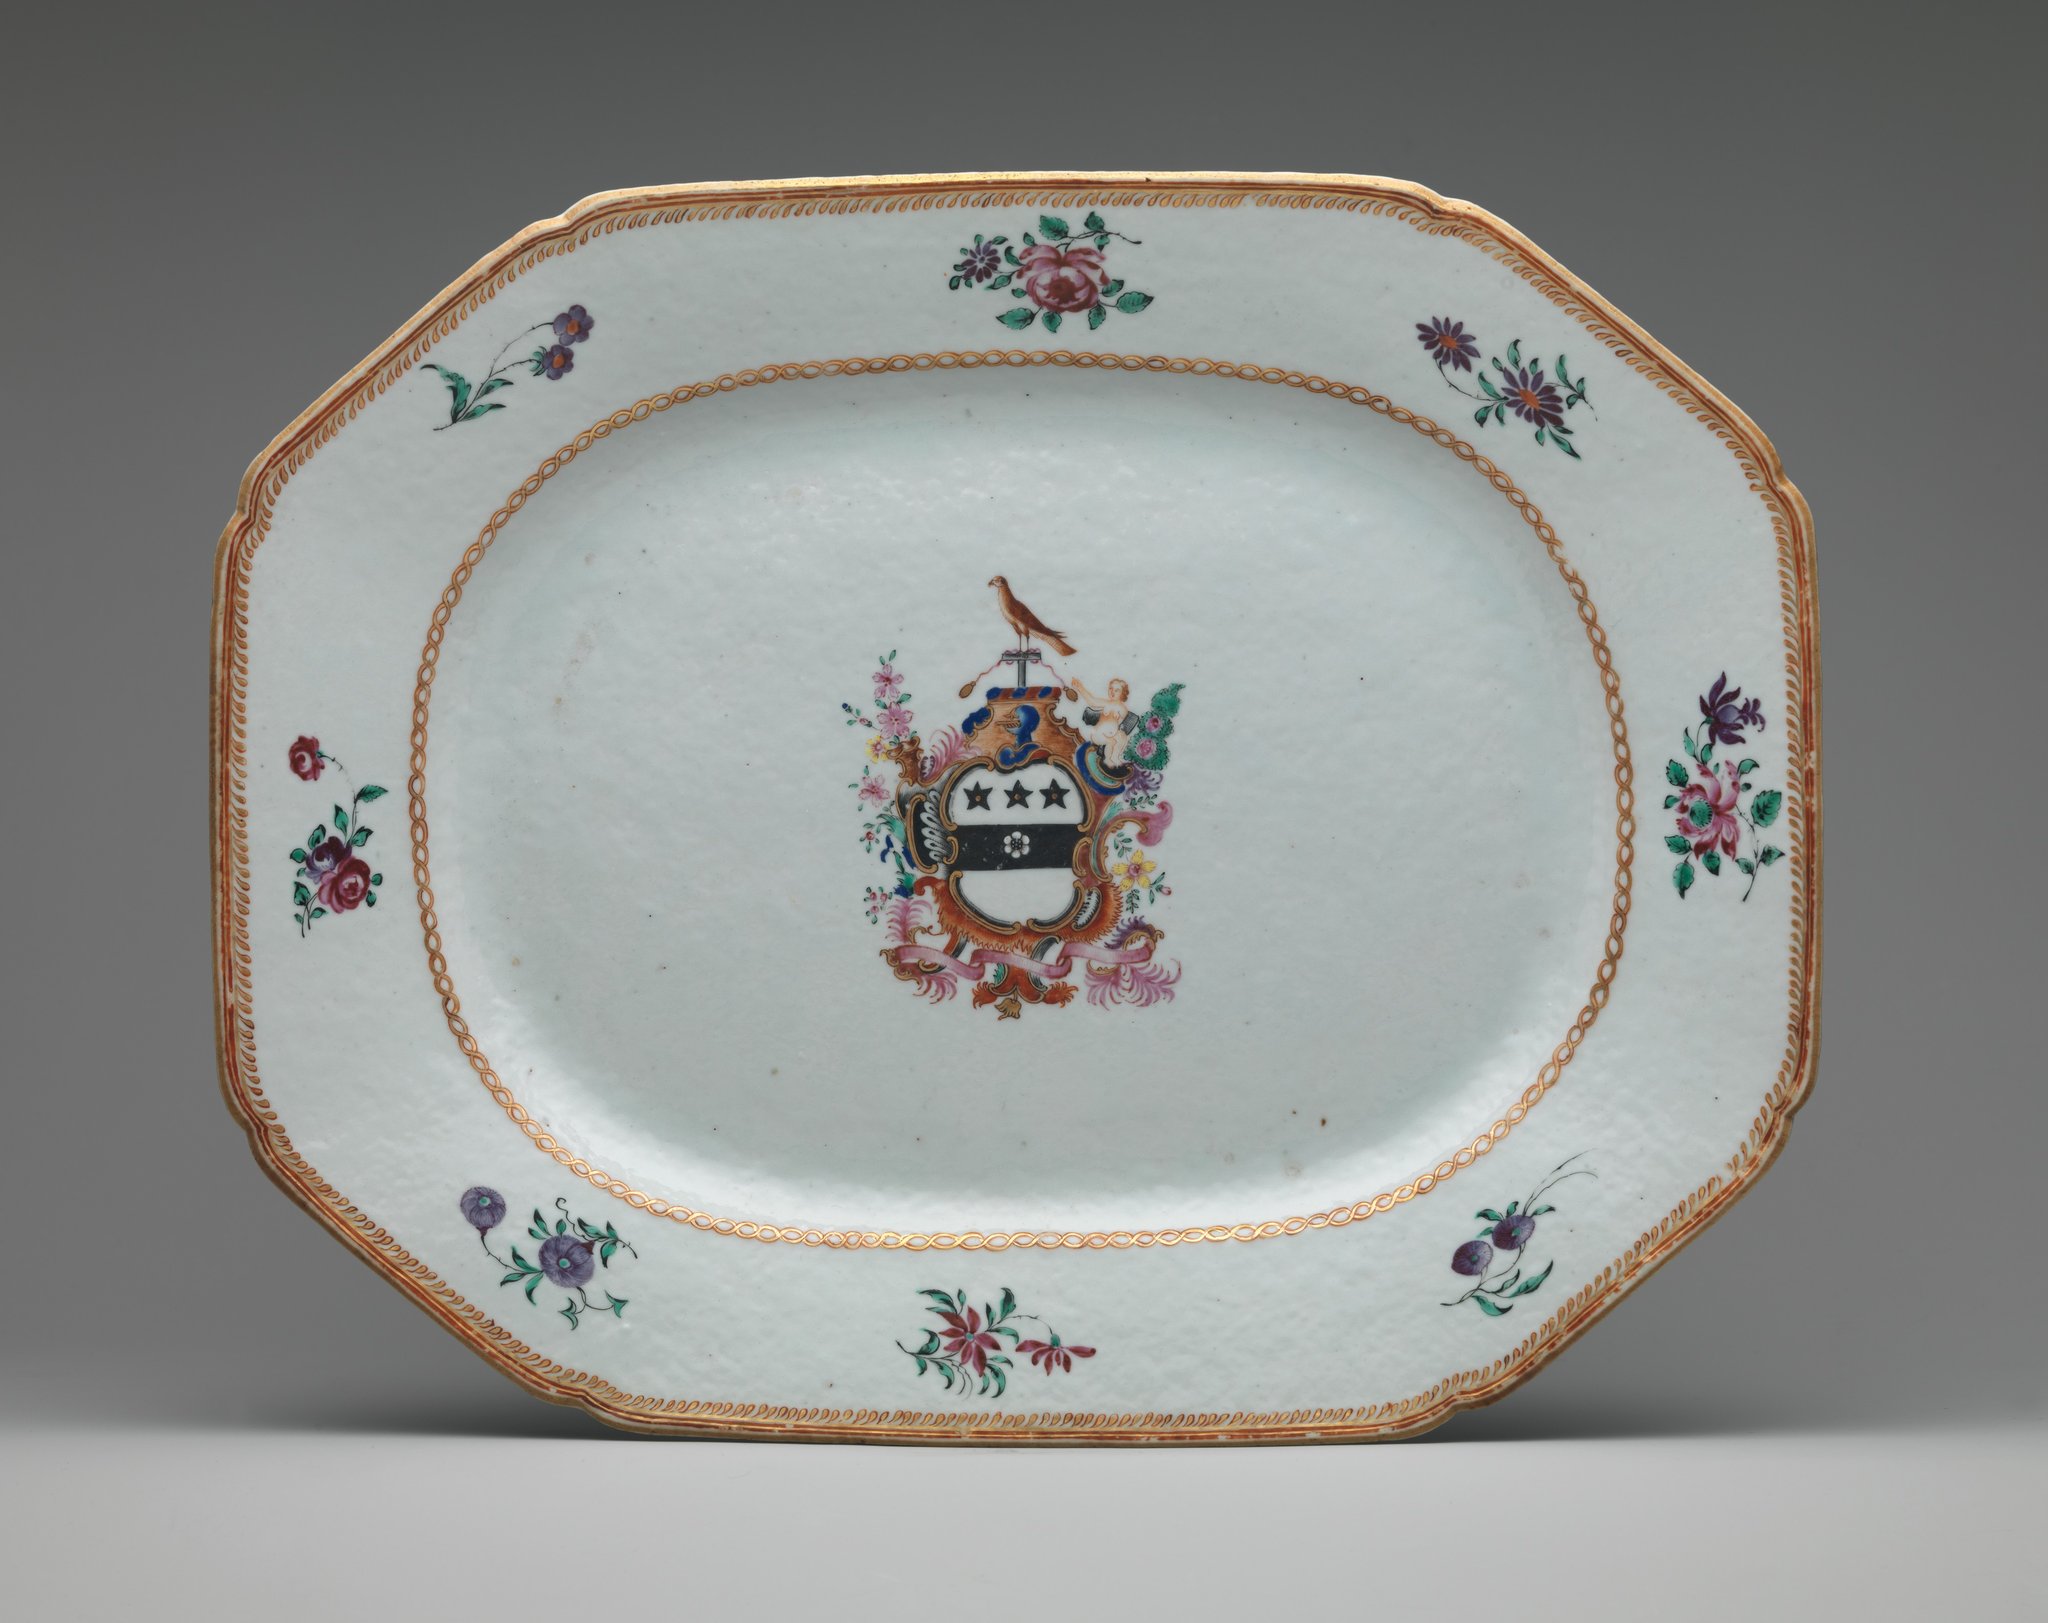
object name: platter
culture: chinese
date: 1785-1790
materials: porcelain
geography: china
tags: birds,flowers,coat of arms